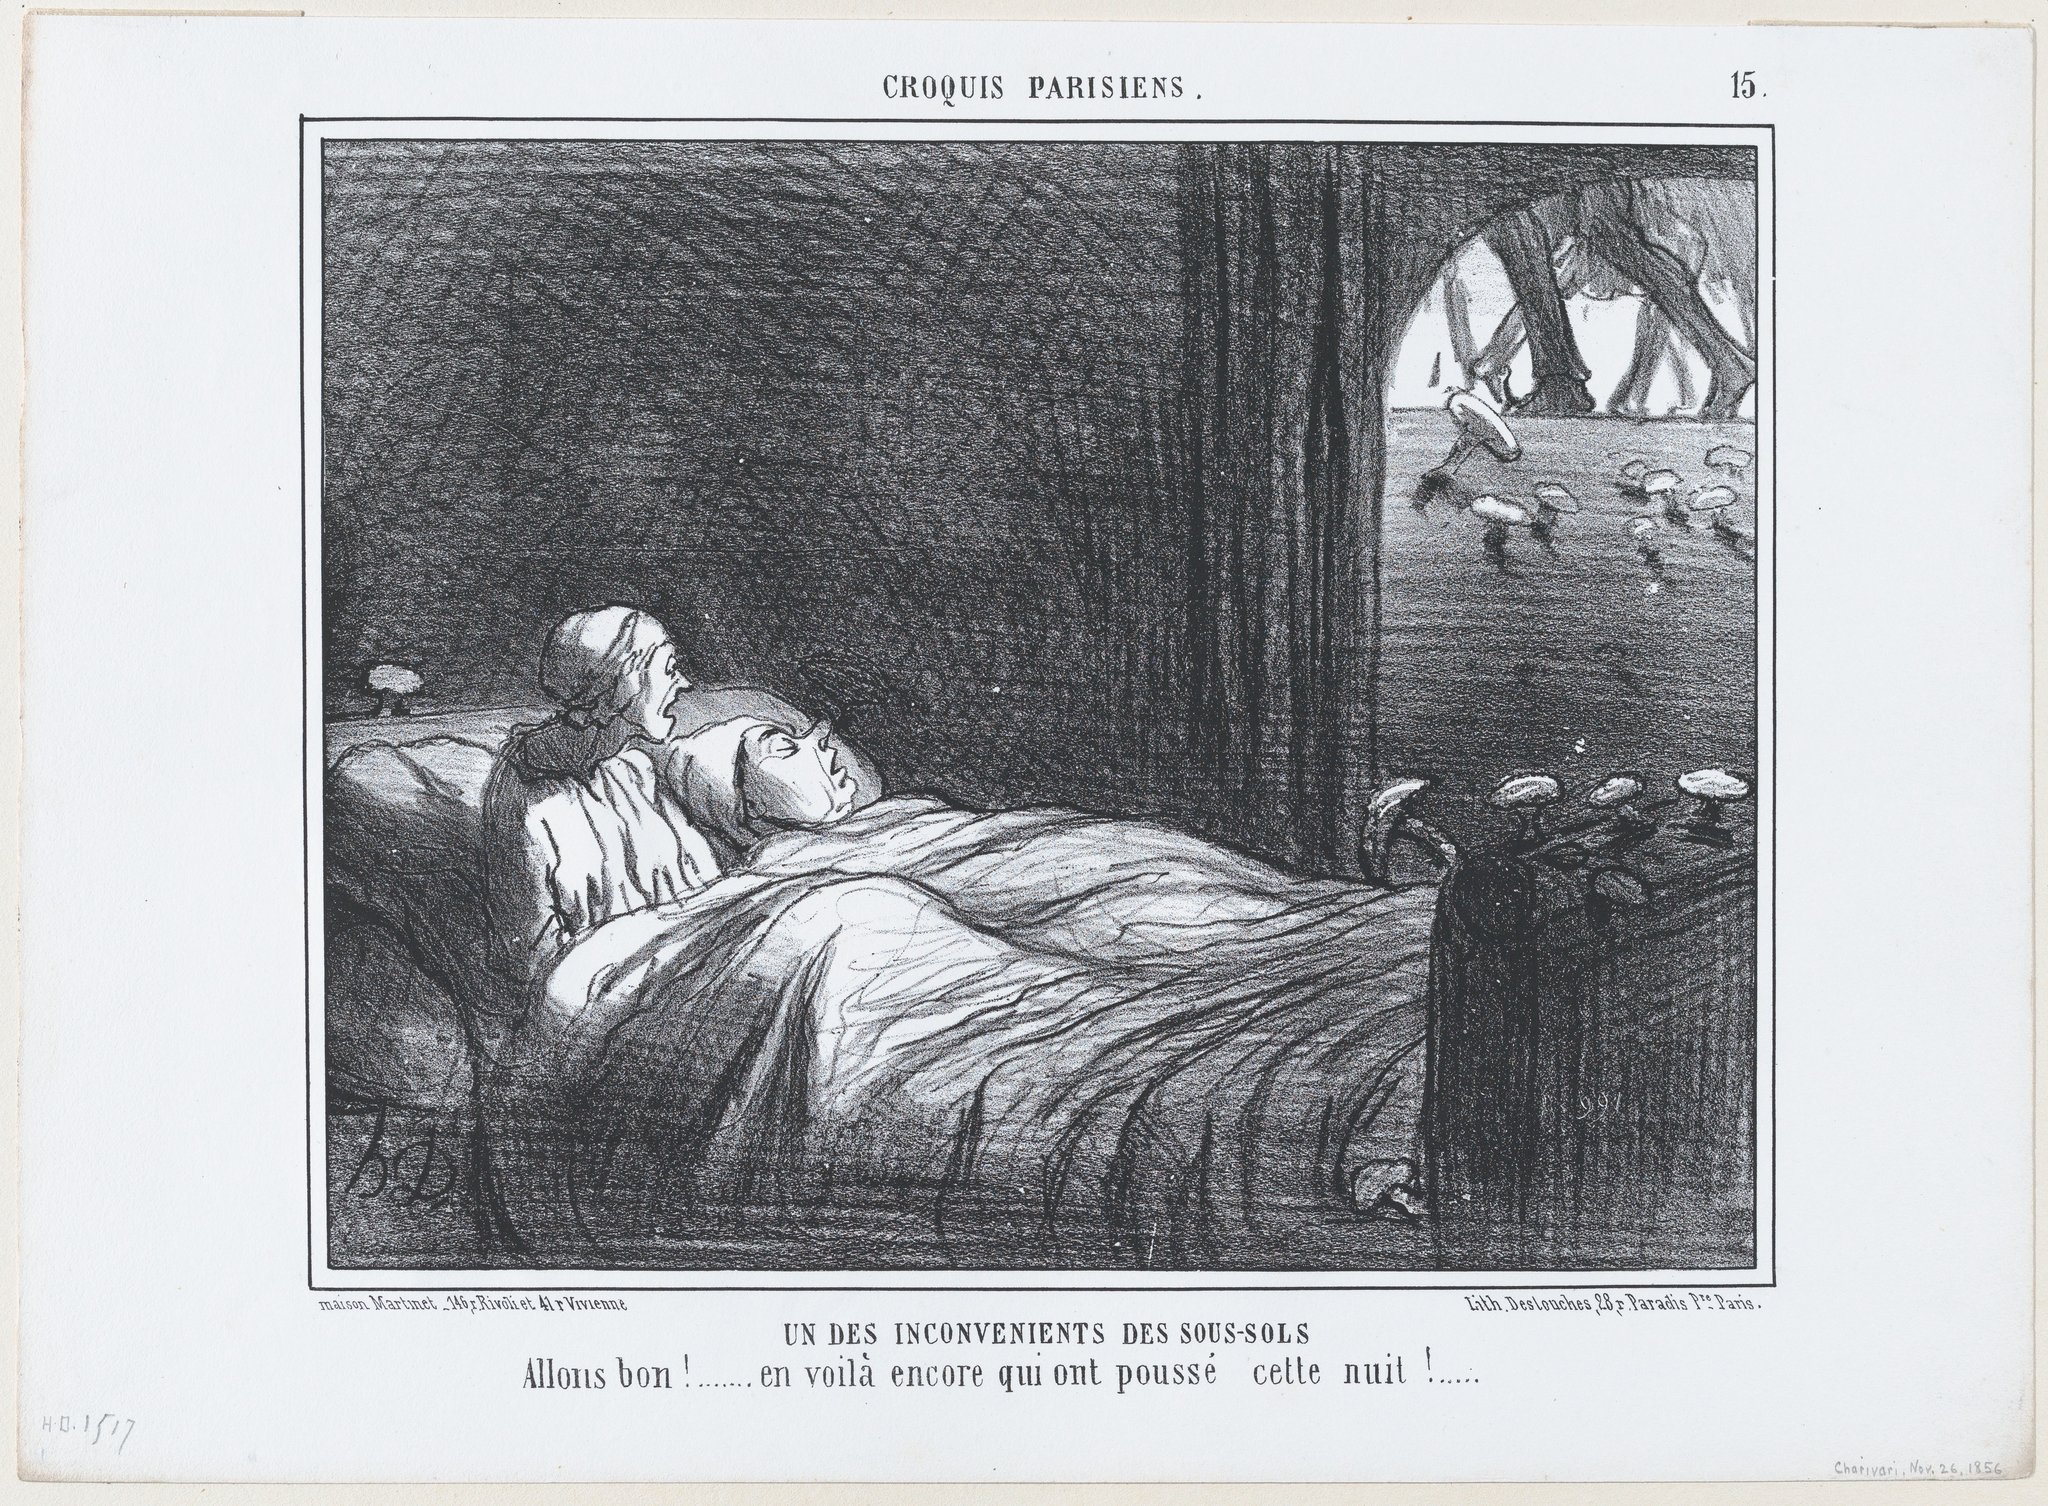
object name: print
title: Un des inconvénients des sous-sols, from Croqius Parisiens, published in Le Charivari, November 26, 1856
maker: honoré daumier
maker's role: artist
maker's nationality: french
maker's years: 1808-1879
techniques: lithograph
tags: men,women